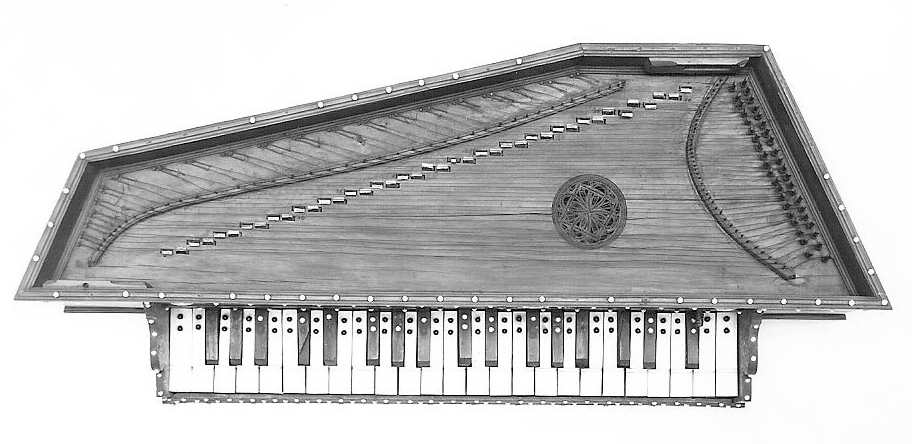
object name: polygonal virginal converted to a tangent piano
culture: italian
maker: franciscus bonafinis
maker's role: maker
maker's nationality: italian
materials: wood, ivory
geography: italy